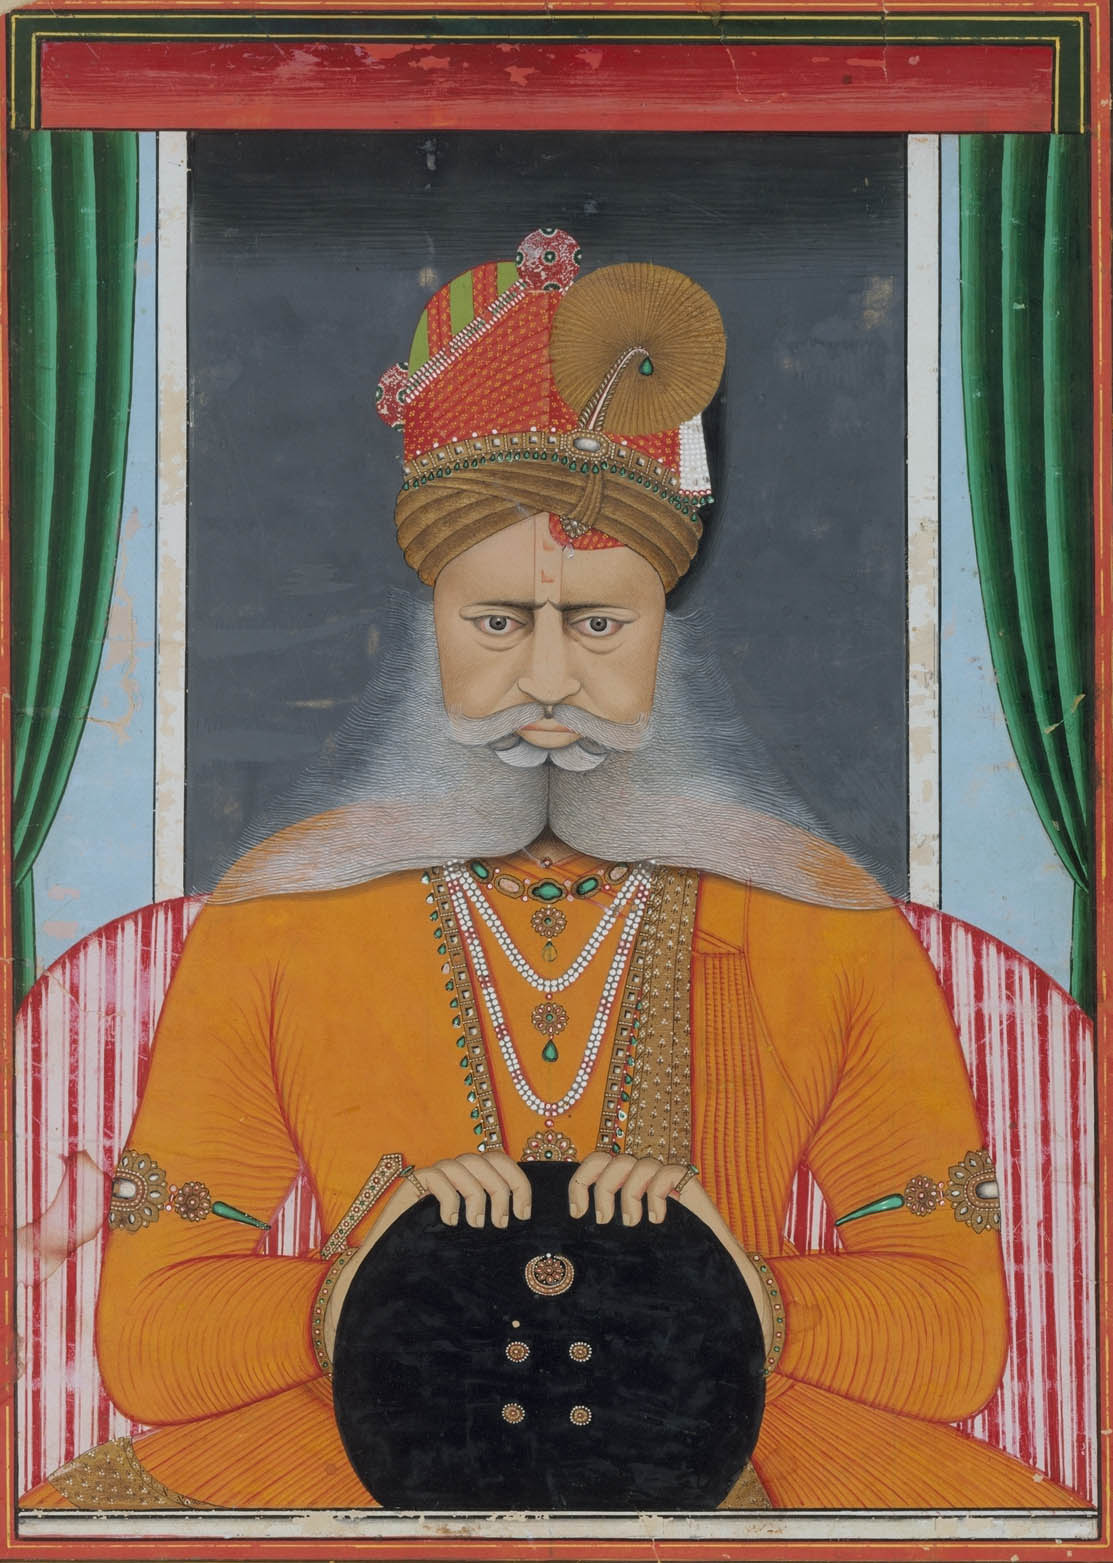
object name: painting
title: Maharaja Sardar Singh of Bikaner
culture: indian, rajasthani, bikaner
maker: chotu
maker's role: artist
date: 1860-1870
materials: gold, ink, paper, watercolor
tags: men,portraits